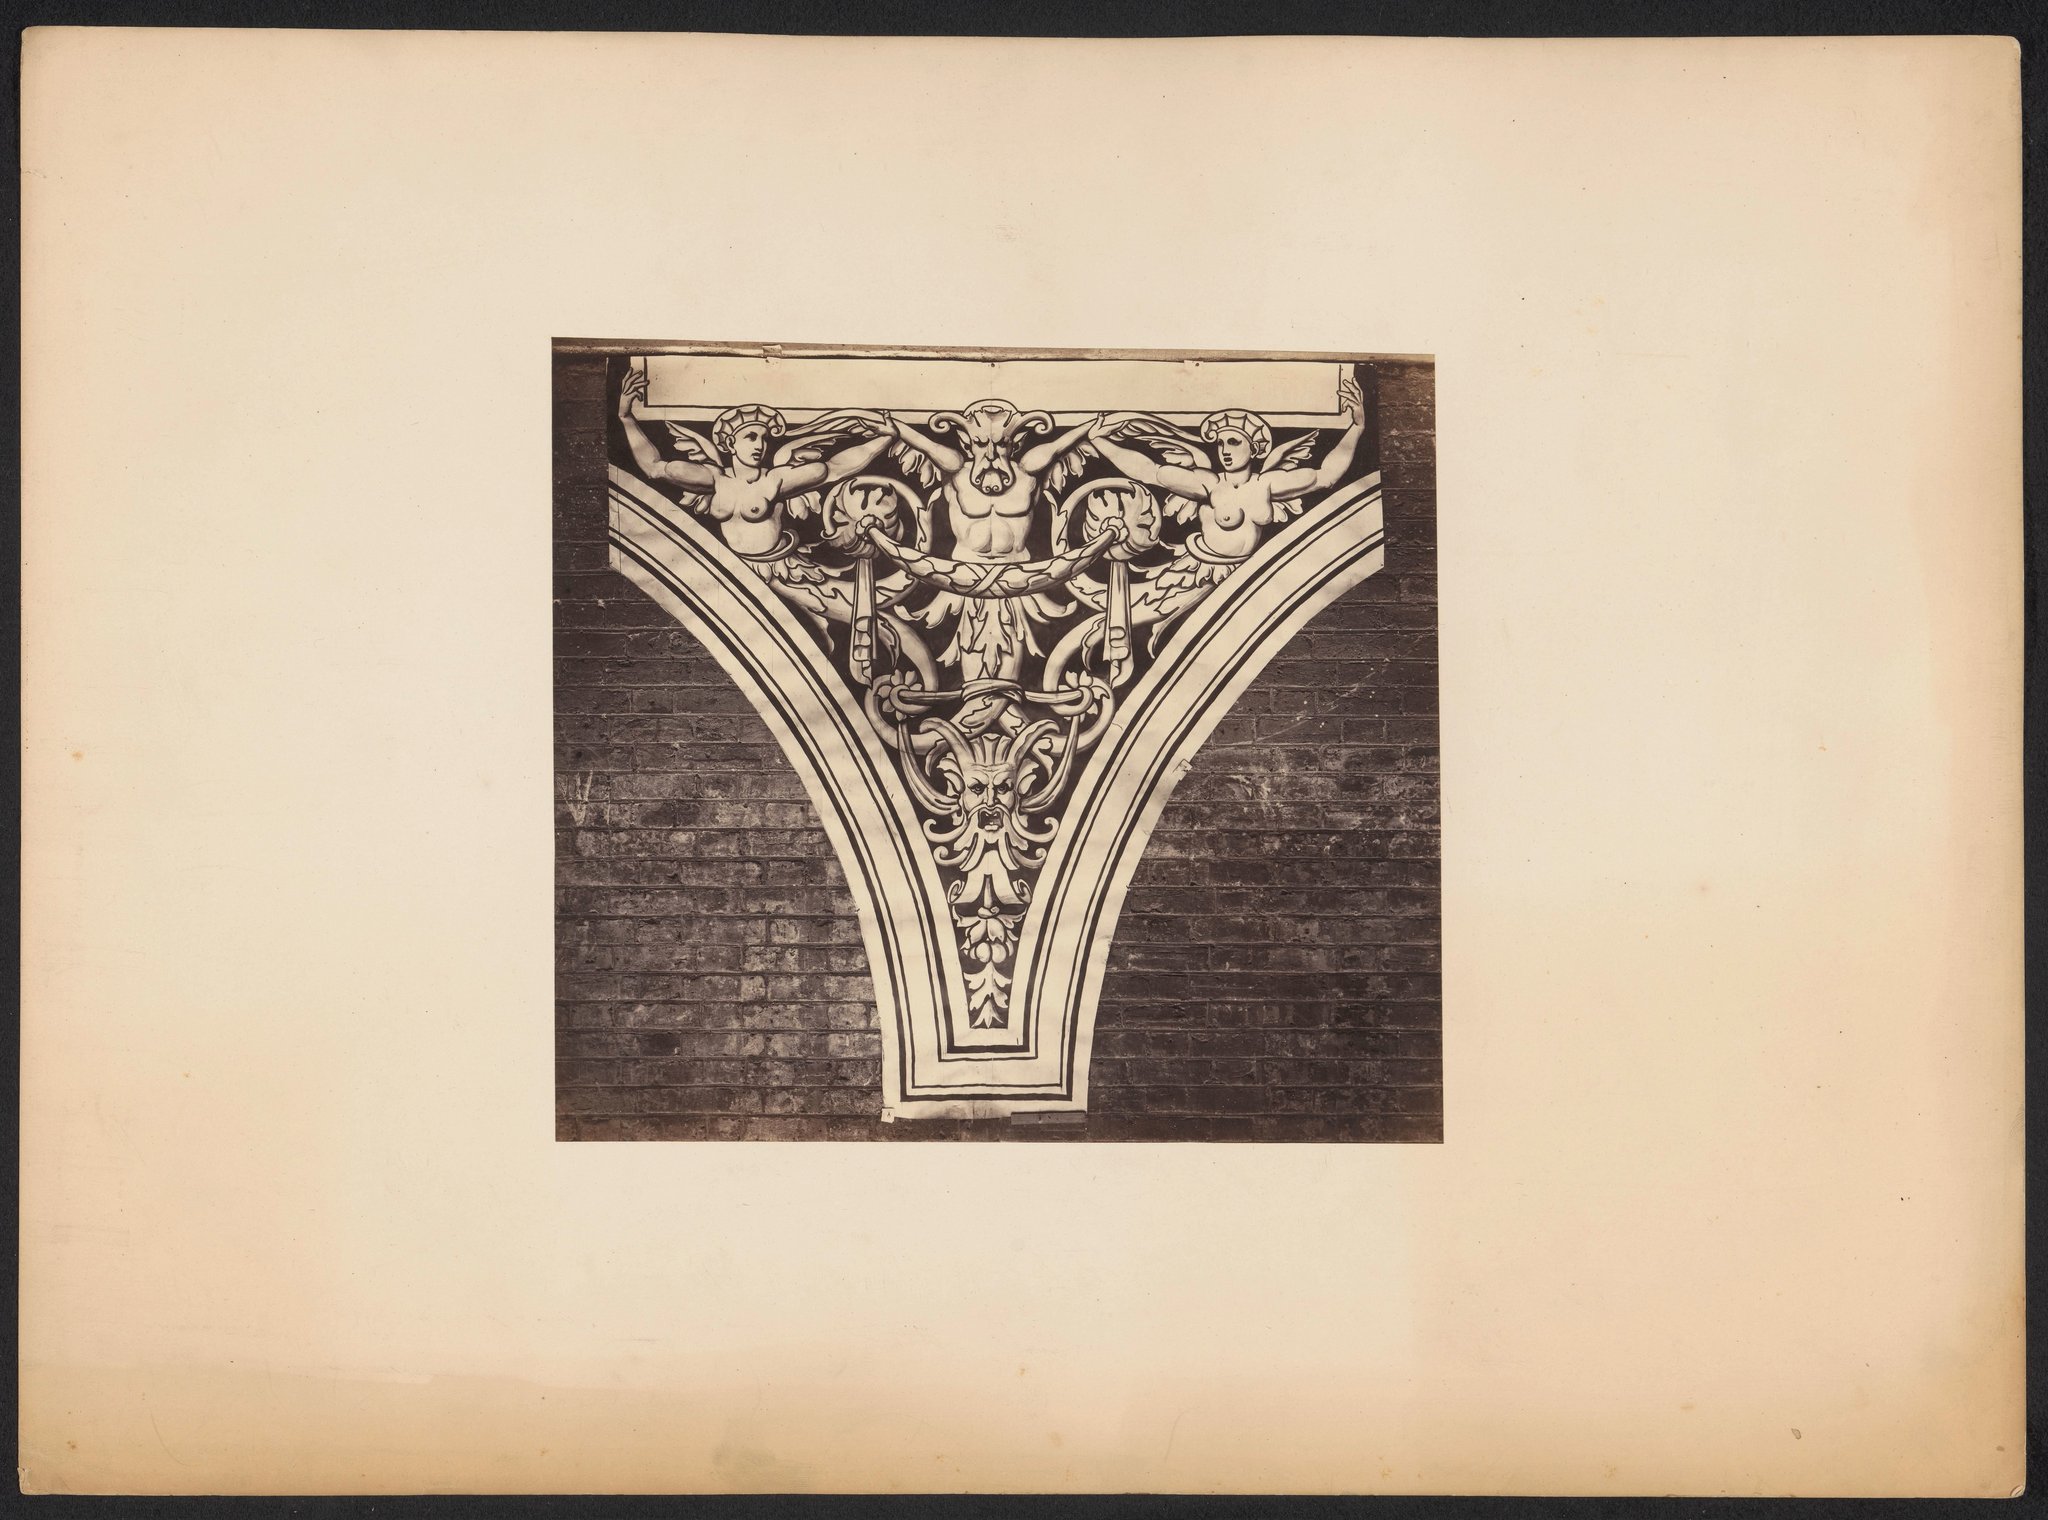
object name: photomontage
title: Ornamentprent met gevleugelde vrouwenfiguren en een maskerkop op een muur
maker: Anonymous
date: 1875-1900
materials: cardboard, photographic support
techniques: albumen print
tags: fabulous beings with wings - aa - female human figure, other fantasy ornament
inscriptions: collector's mark: Lugt 3937